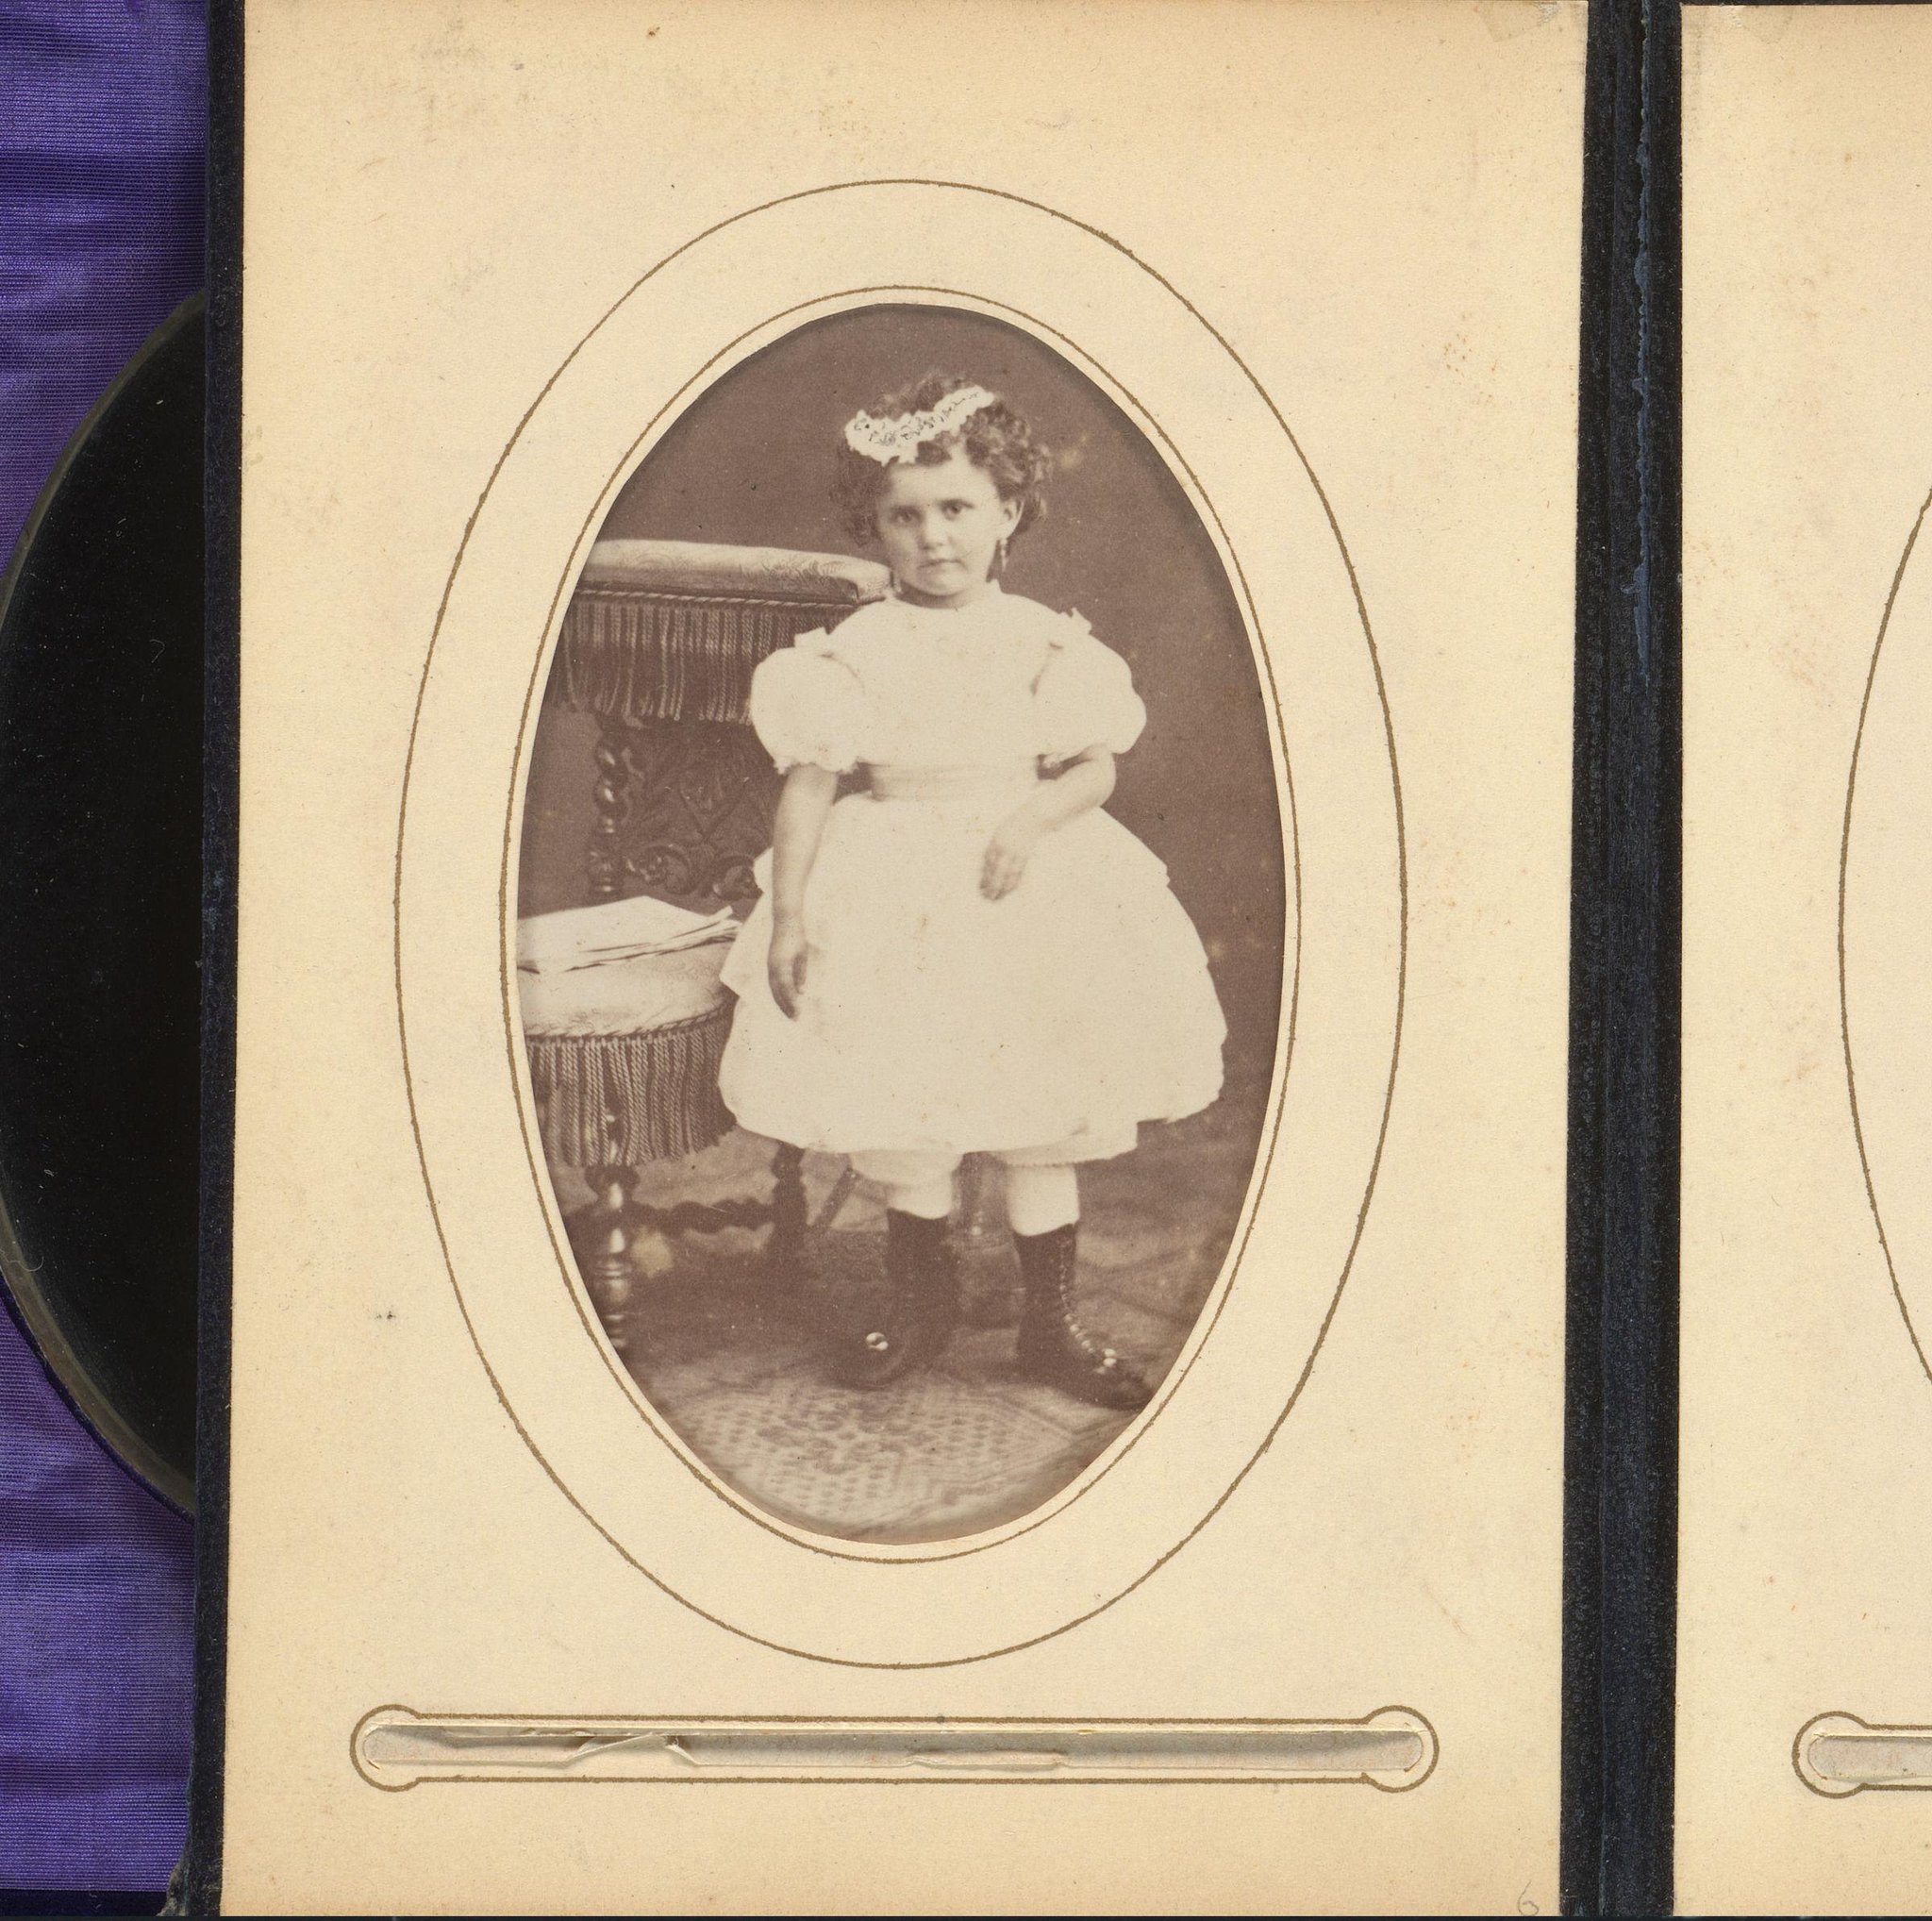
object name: photograph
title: Portret van een meisje, staand bij een stoel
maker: frederik harting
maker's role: fotograaf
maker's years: 1835-1902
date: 1863-1899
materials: cardboard, photographic support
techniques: albumen print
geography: gouda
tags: historical persons - bb - woman, toddler (female), standing figure - aa - female human figure, chair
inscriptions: inscription: ‘F. HARTING/ PHOTOGRAPHE/ GOUDA’